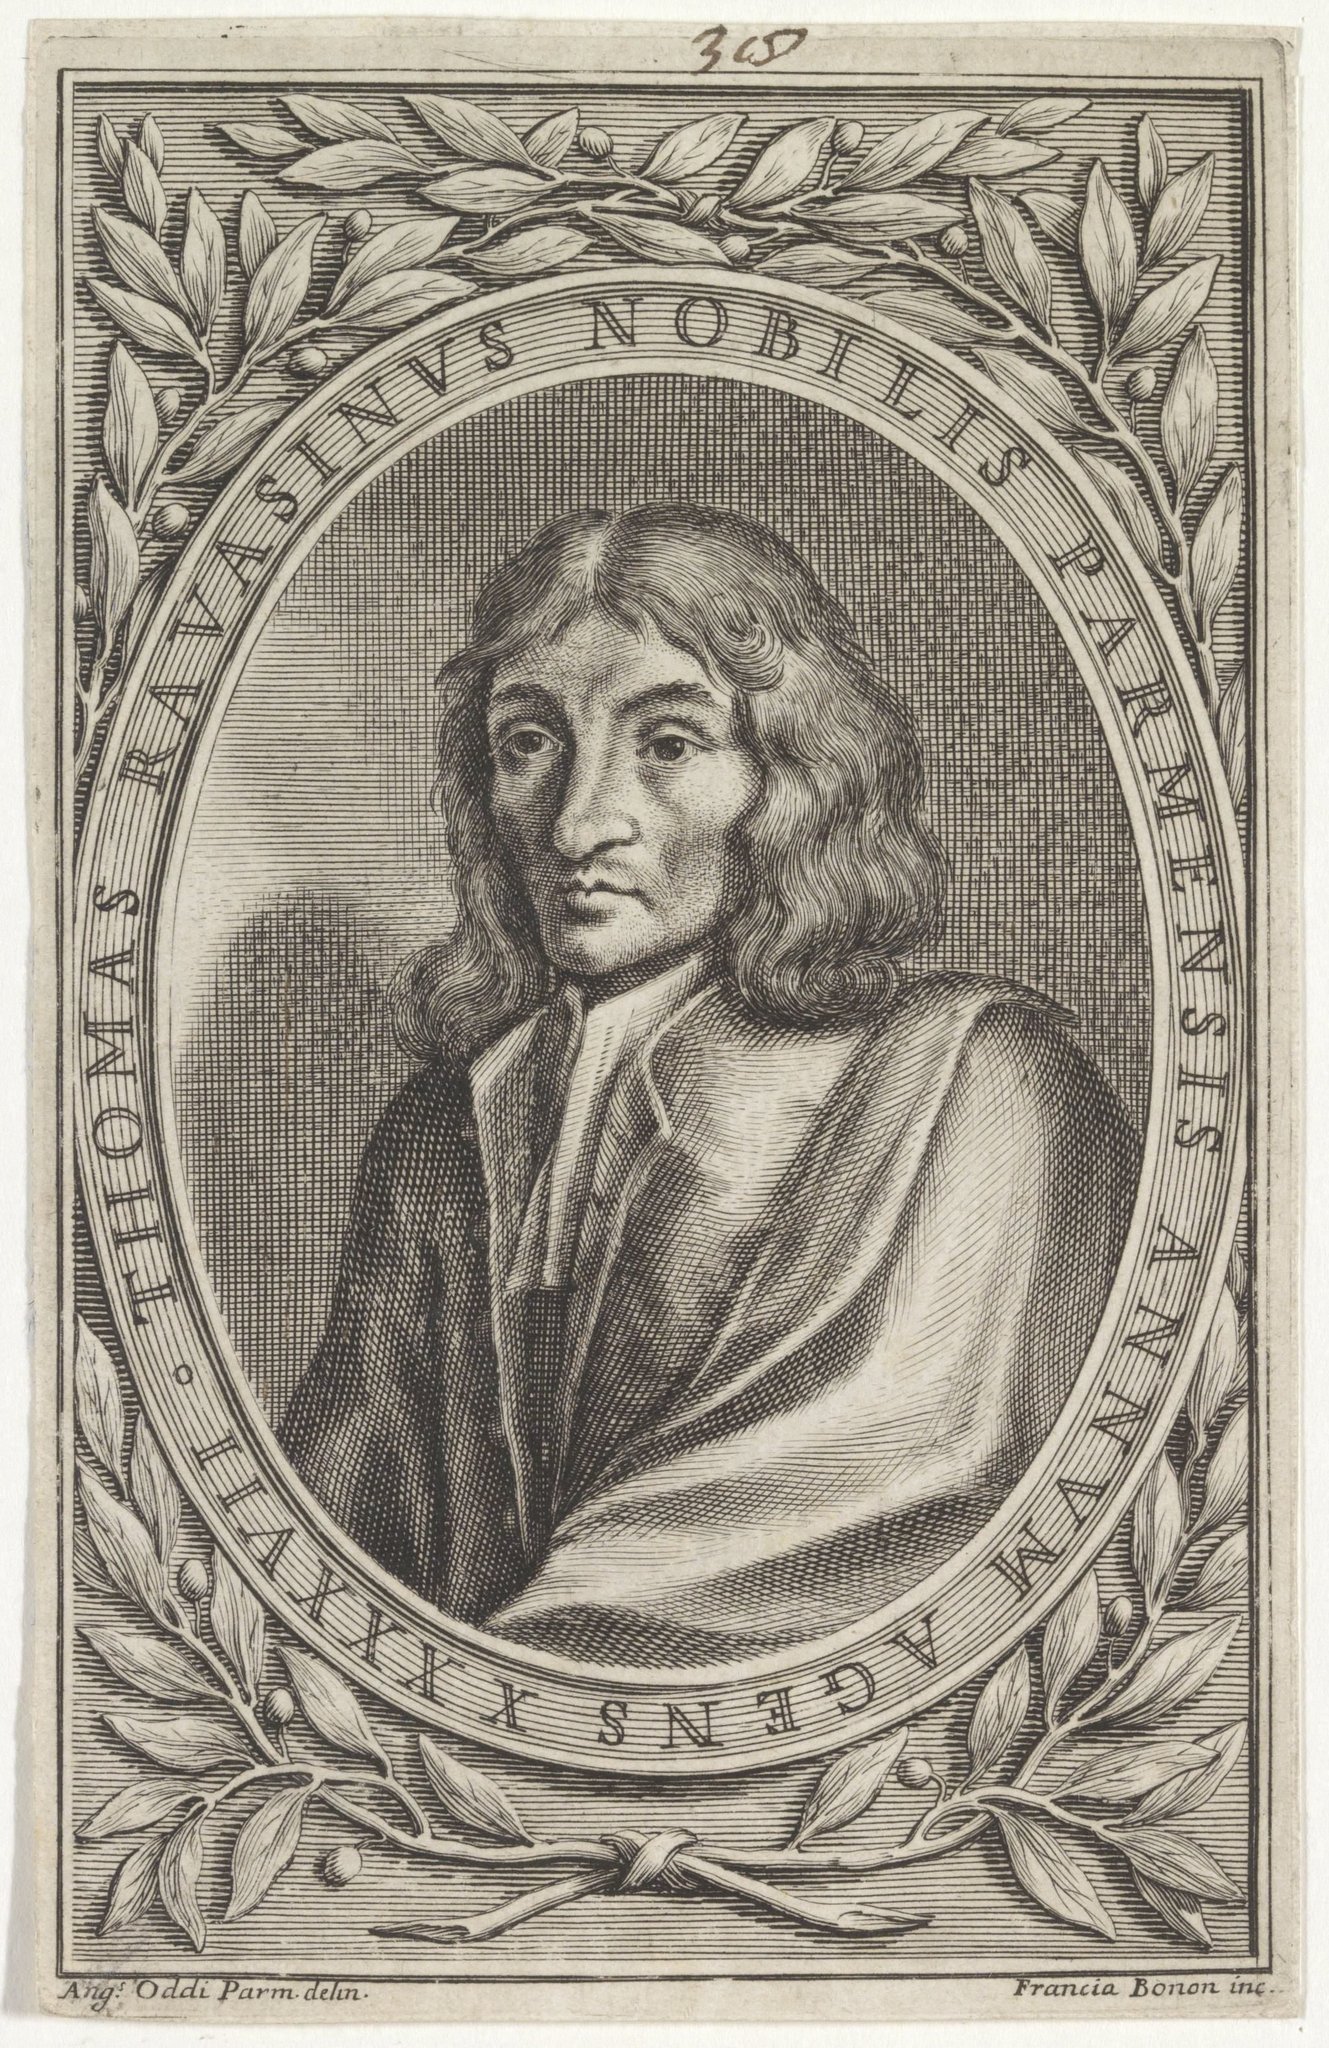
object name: print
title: Portret van Thomas Ravasini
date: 1667-1735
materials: paper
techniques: engraving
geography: italy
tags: historical persons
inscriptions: collector's mark: Lugt 2228, number: ‘38’